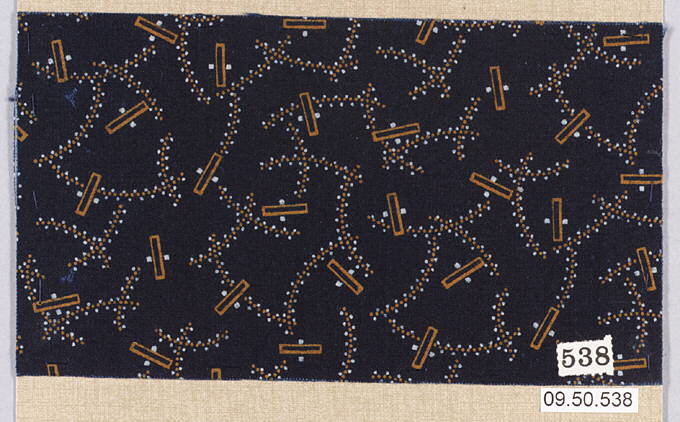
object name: piece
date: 1801-1900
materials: cotton